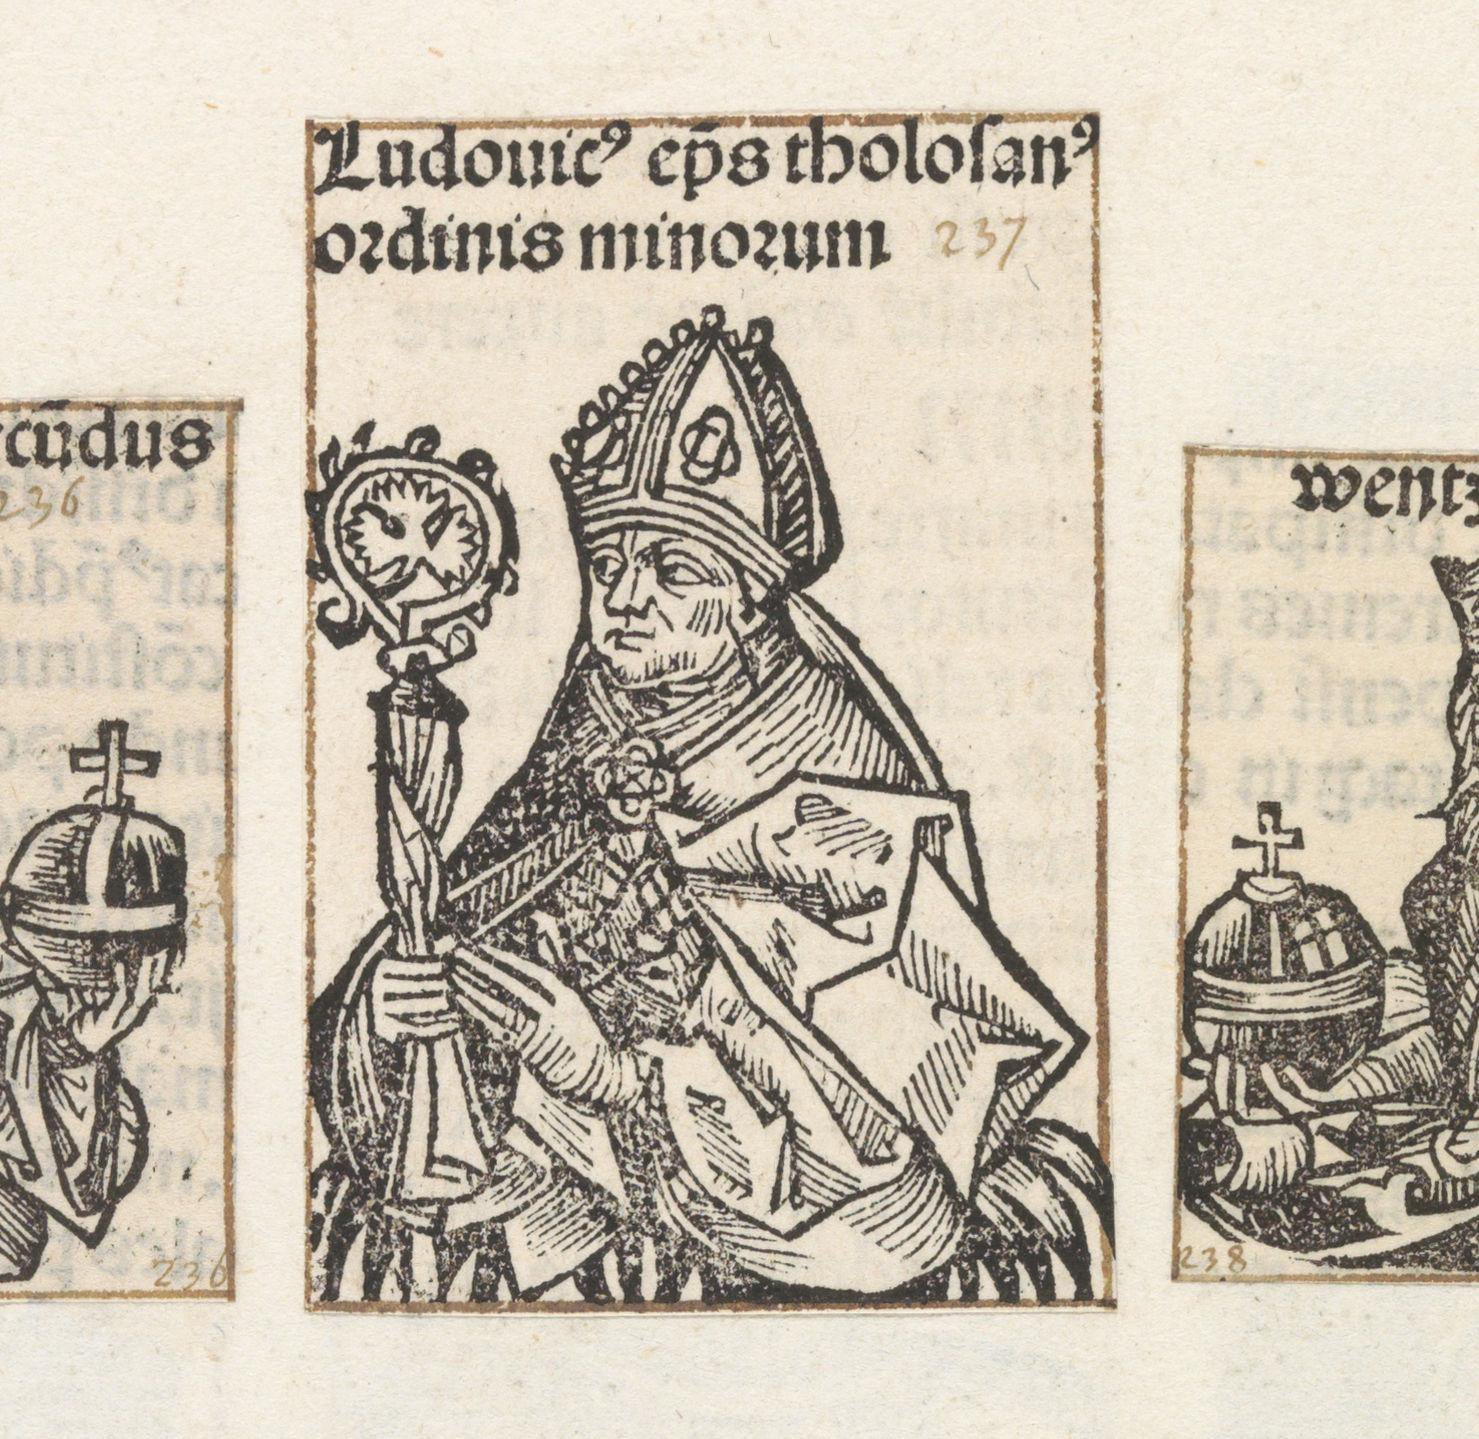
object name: book illustration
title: Bisschop Lodewijk van Toulouse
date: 1493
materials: paper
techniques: letterpress printing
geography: nuremberg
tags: archbishop, bishop, etc. (roman catholic)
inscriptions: inscription: ‘237’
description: De houtsnede wordt herhaaldelijk gebruikt als boekillustratie in de Liber Chronicarum (of Neurenbergkroniek) van Hartmann Schedel, verschenen in het Latijn en Duits in 1493. Zie de Latijnse uitgave, folio 219v.